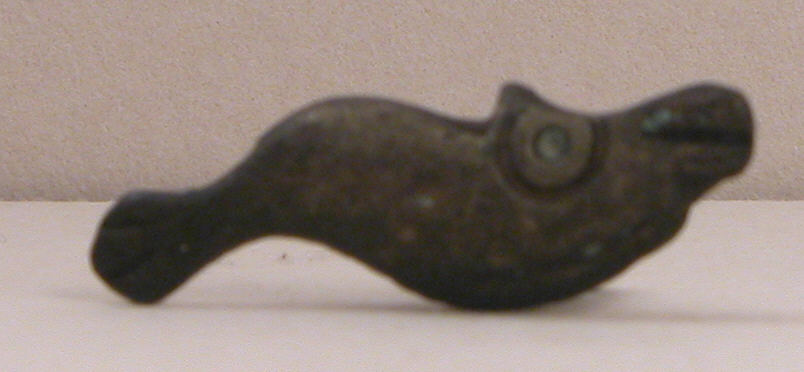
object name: ornament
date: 401-800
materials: bronze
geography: palestine